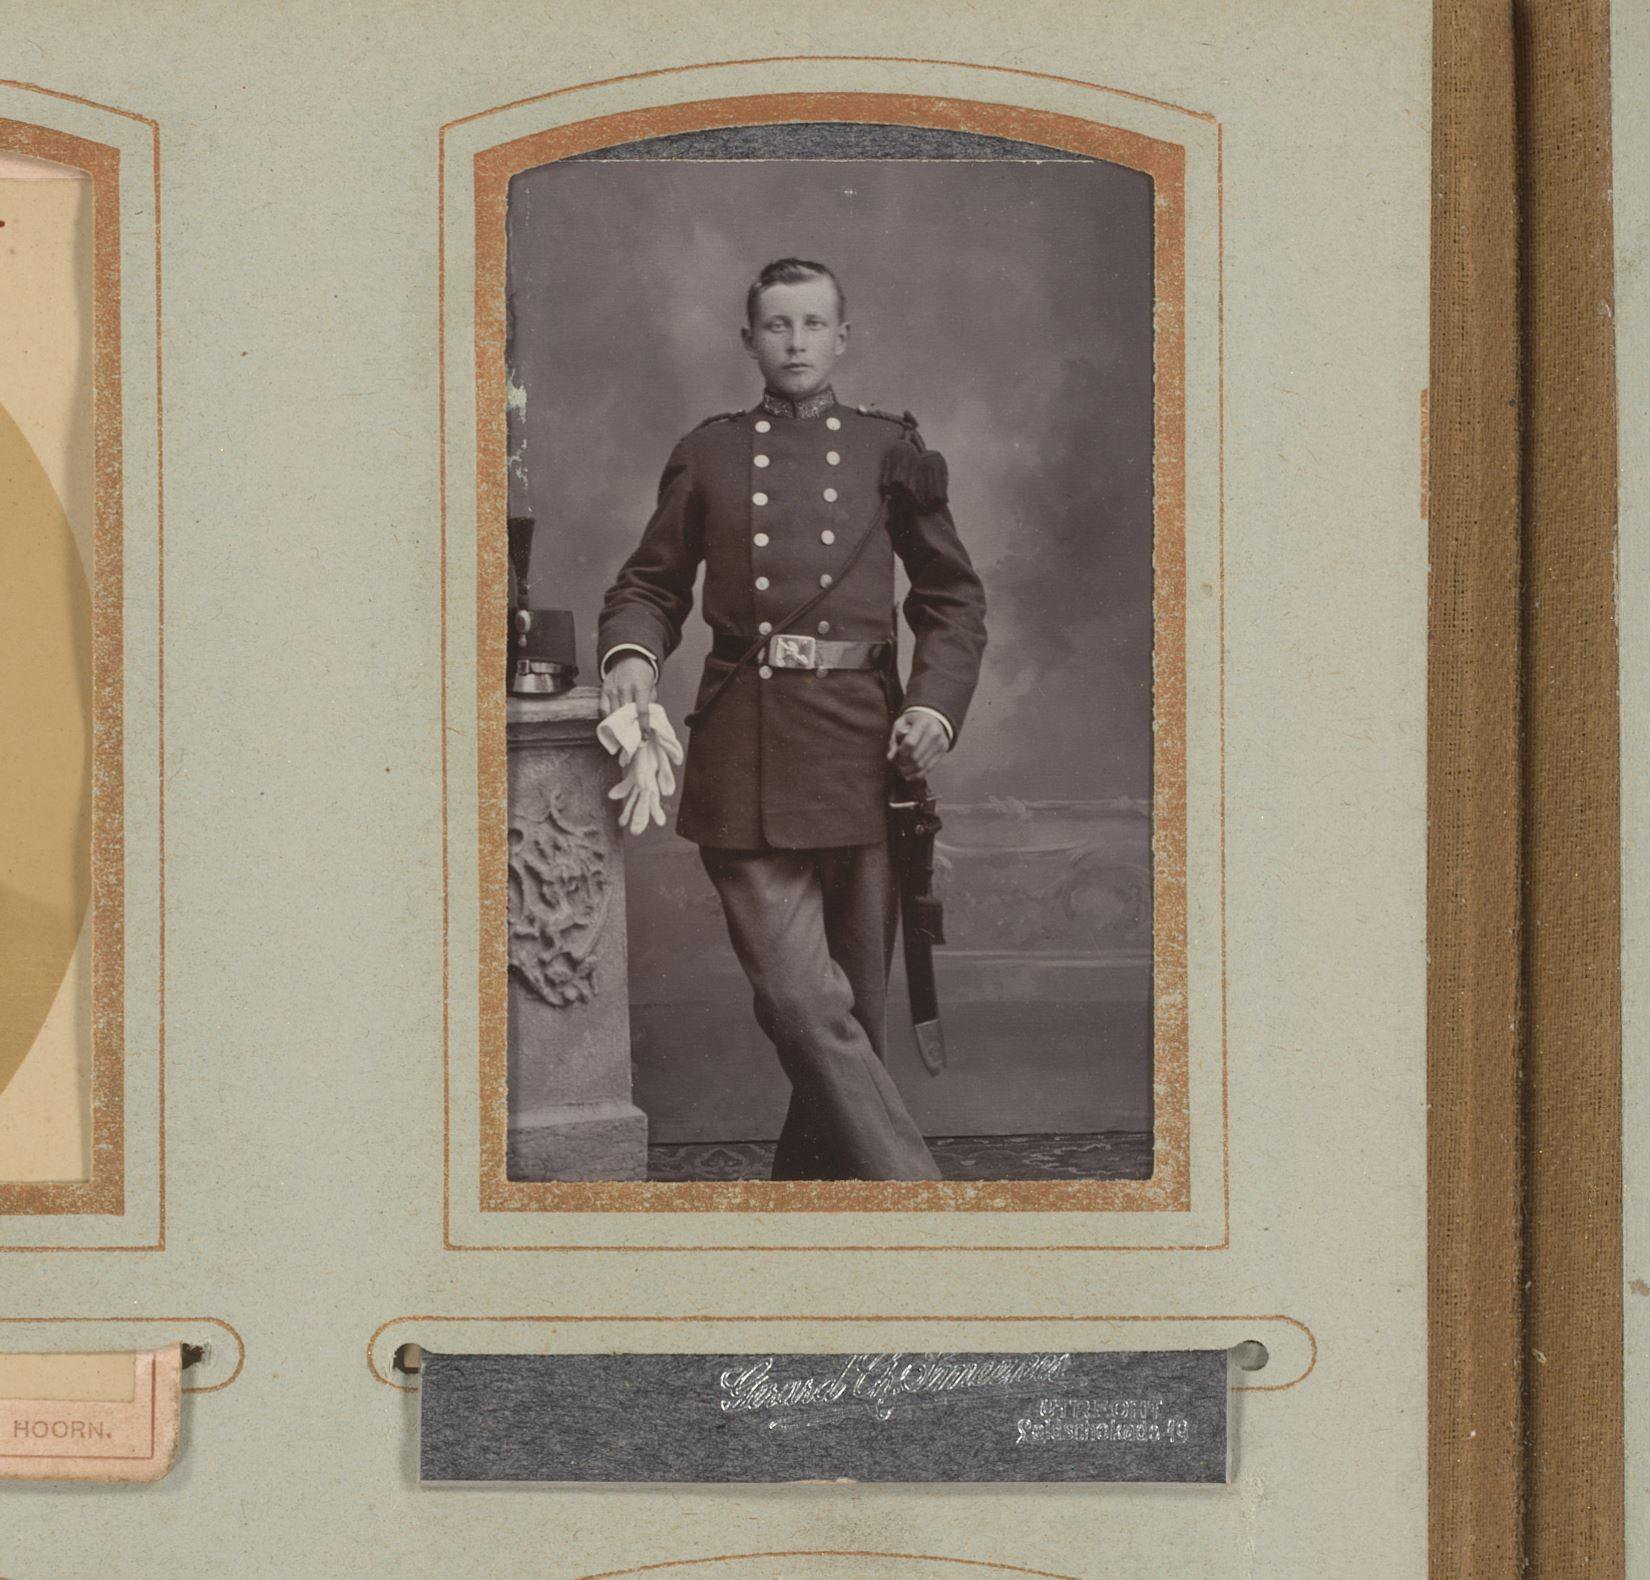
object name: album leaf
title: Portret van een man in uniform met witte handschoenen in de hand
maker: gerardus christiaan smeekes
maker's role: fotograaf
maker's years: 1875-1948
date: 1901-1908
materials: cardboard, photographic support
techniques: daylight paper print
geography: utrecht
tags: gloves, mittens, etc., historical persons, (military) uniforms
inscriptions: inscription: ‘Gerard Ch. Smeekes/ Fotograaf/ UTRECHT/ Leidschekade 19./ Telefoon 1418./ Vergrootingen naar oude en verbleekte portretten./ specialiteit in buitenopnamen./ men lette vooral op het huisnummer.’